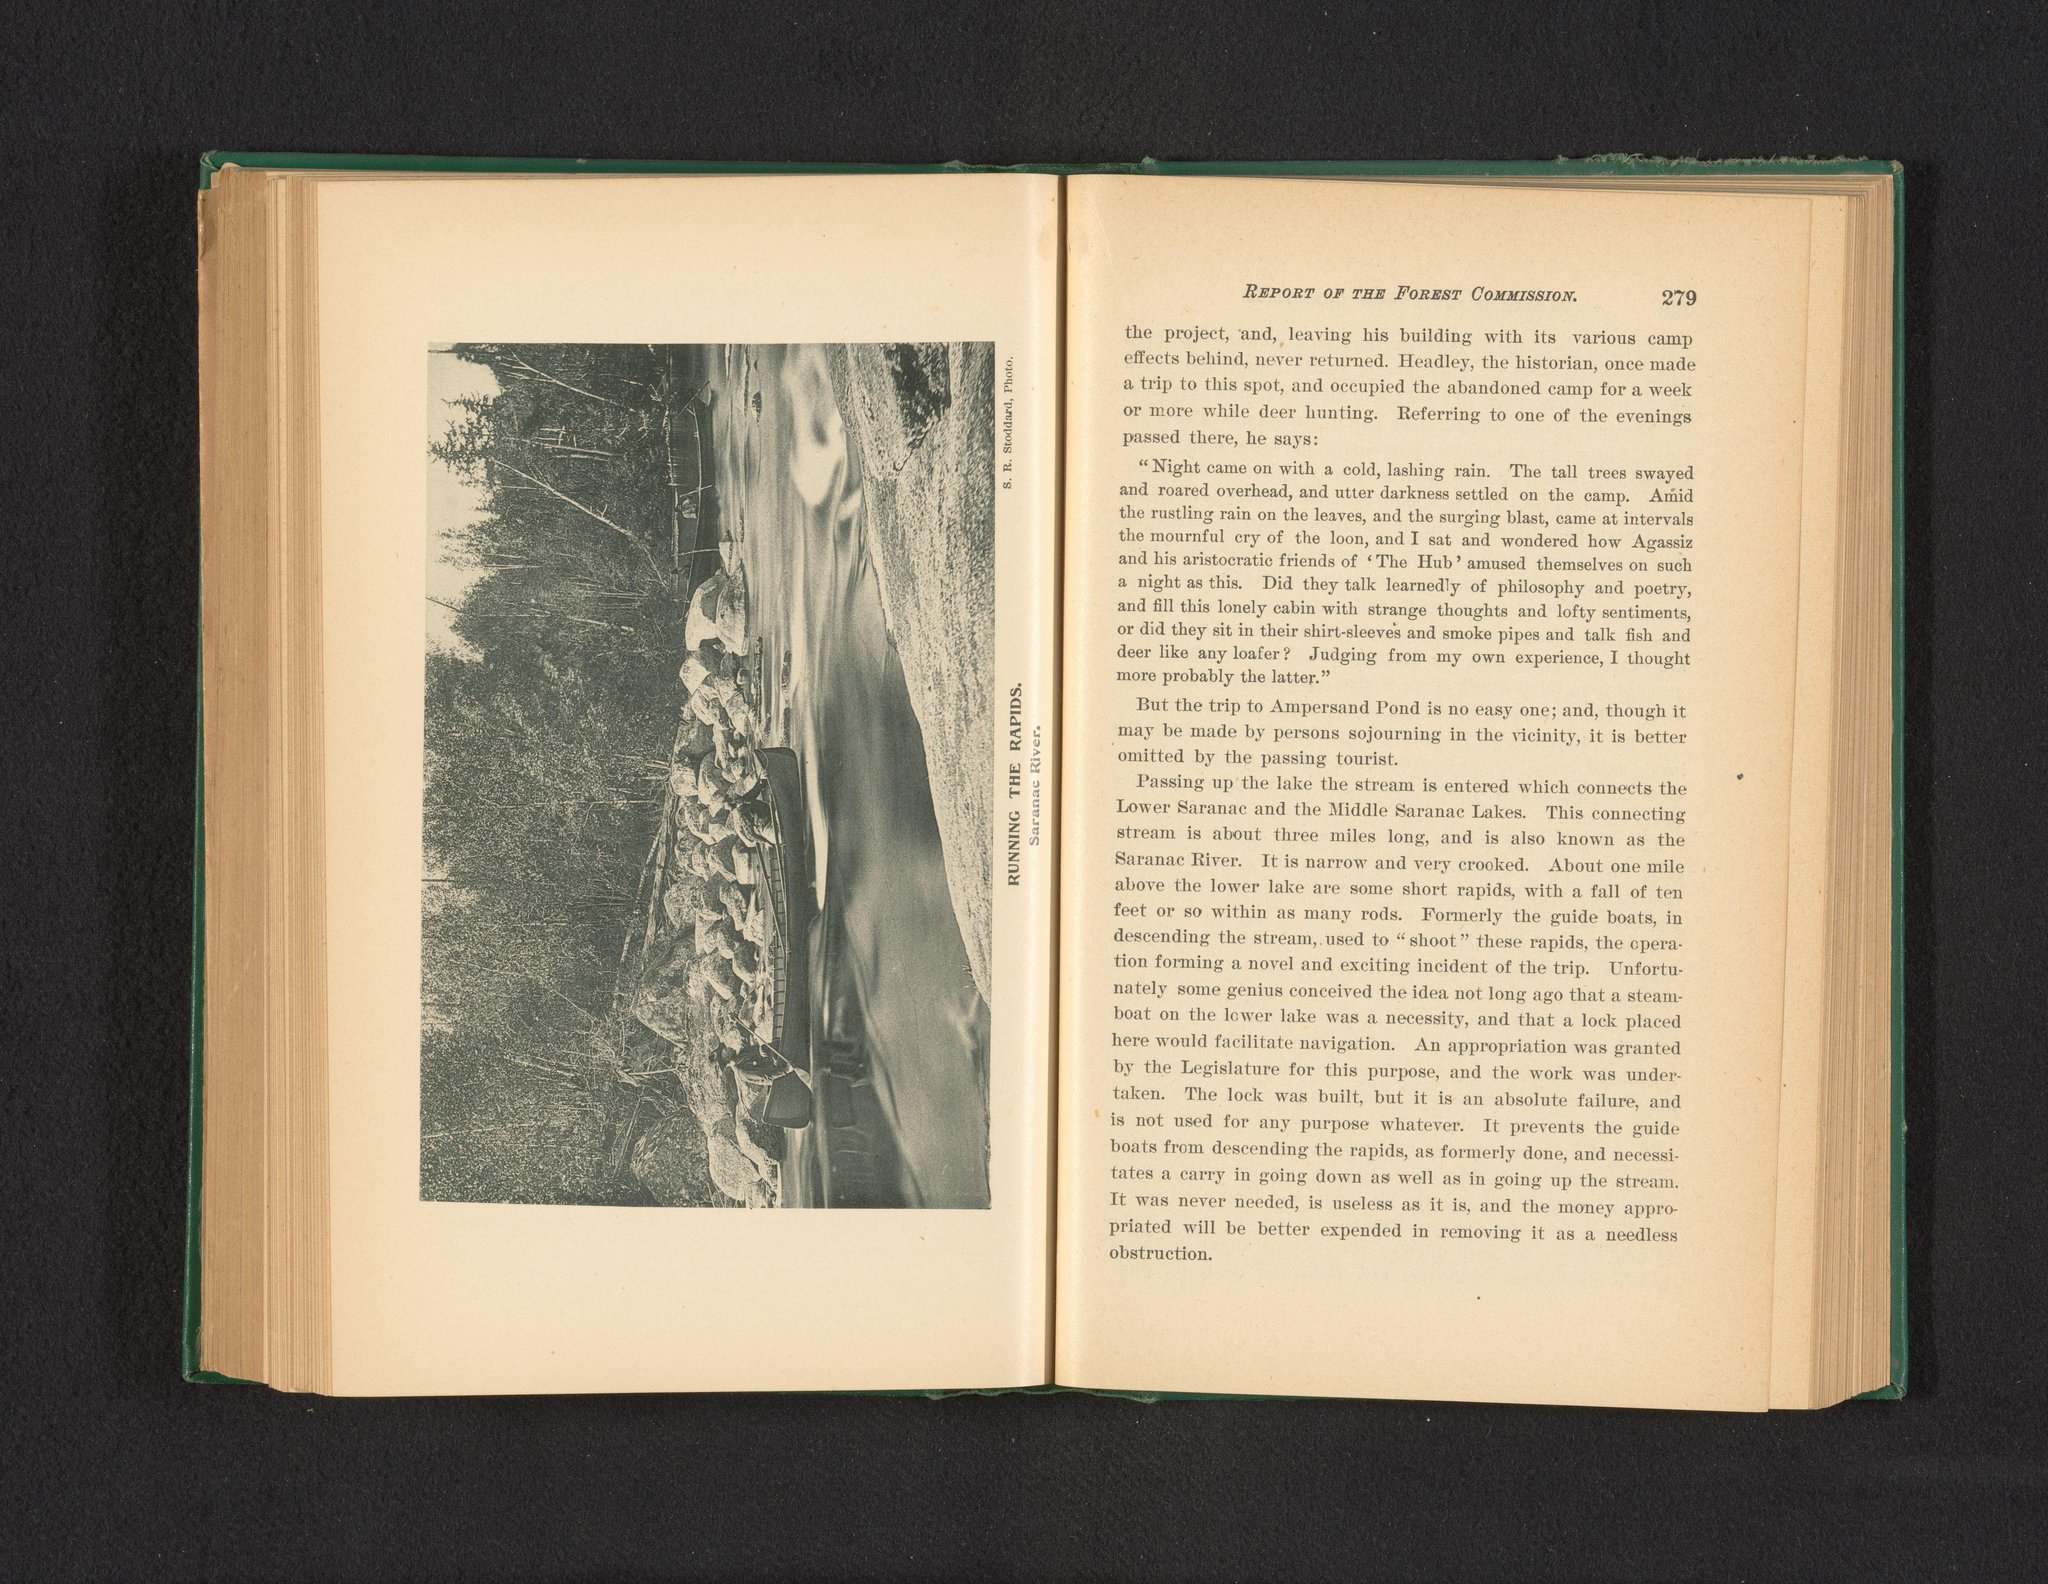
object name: photomechanical print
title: Running the rapids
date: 1893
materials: paper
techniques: photograph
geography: new york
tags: rapids, rowing-boat, canoe, etc.